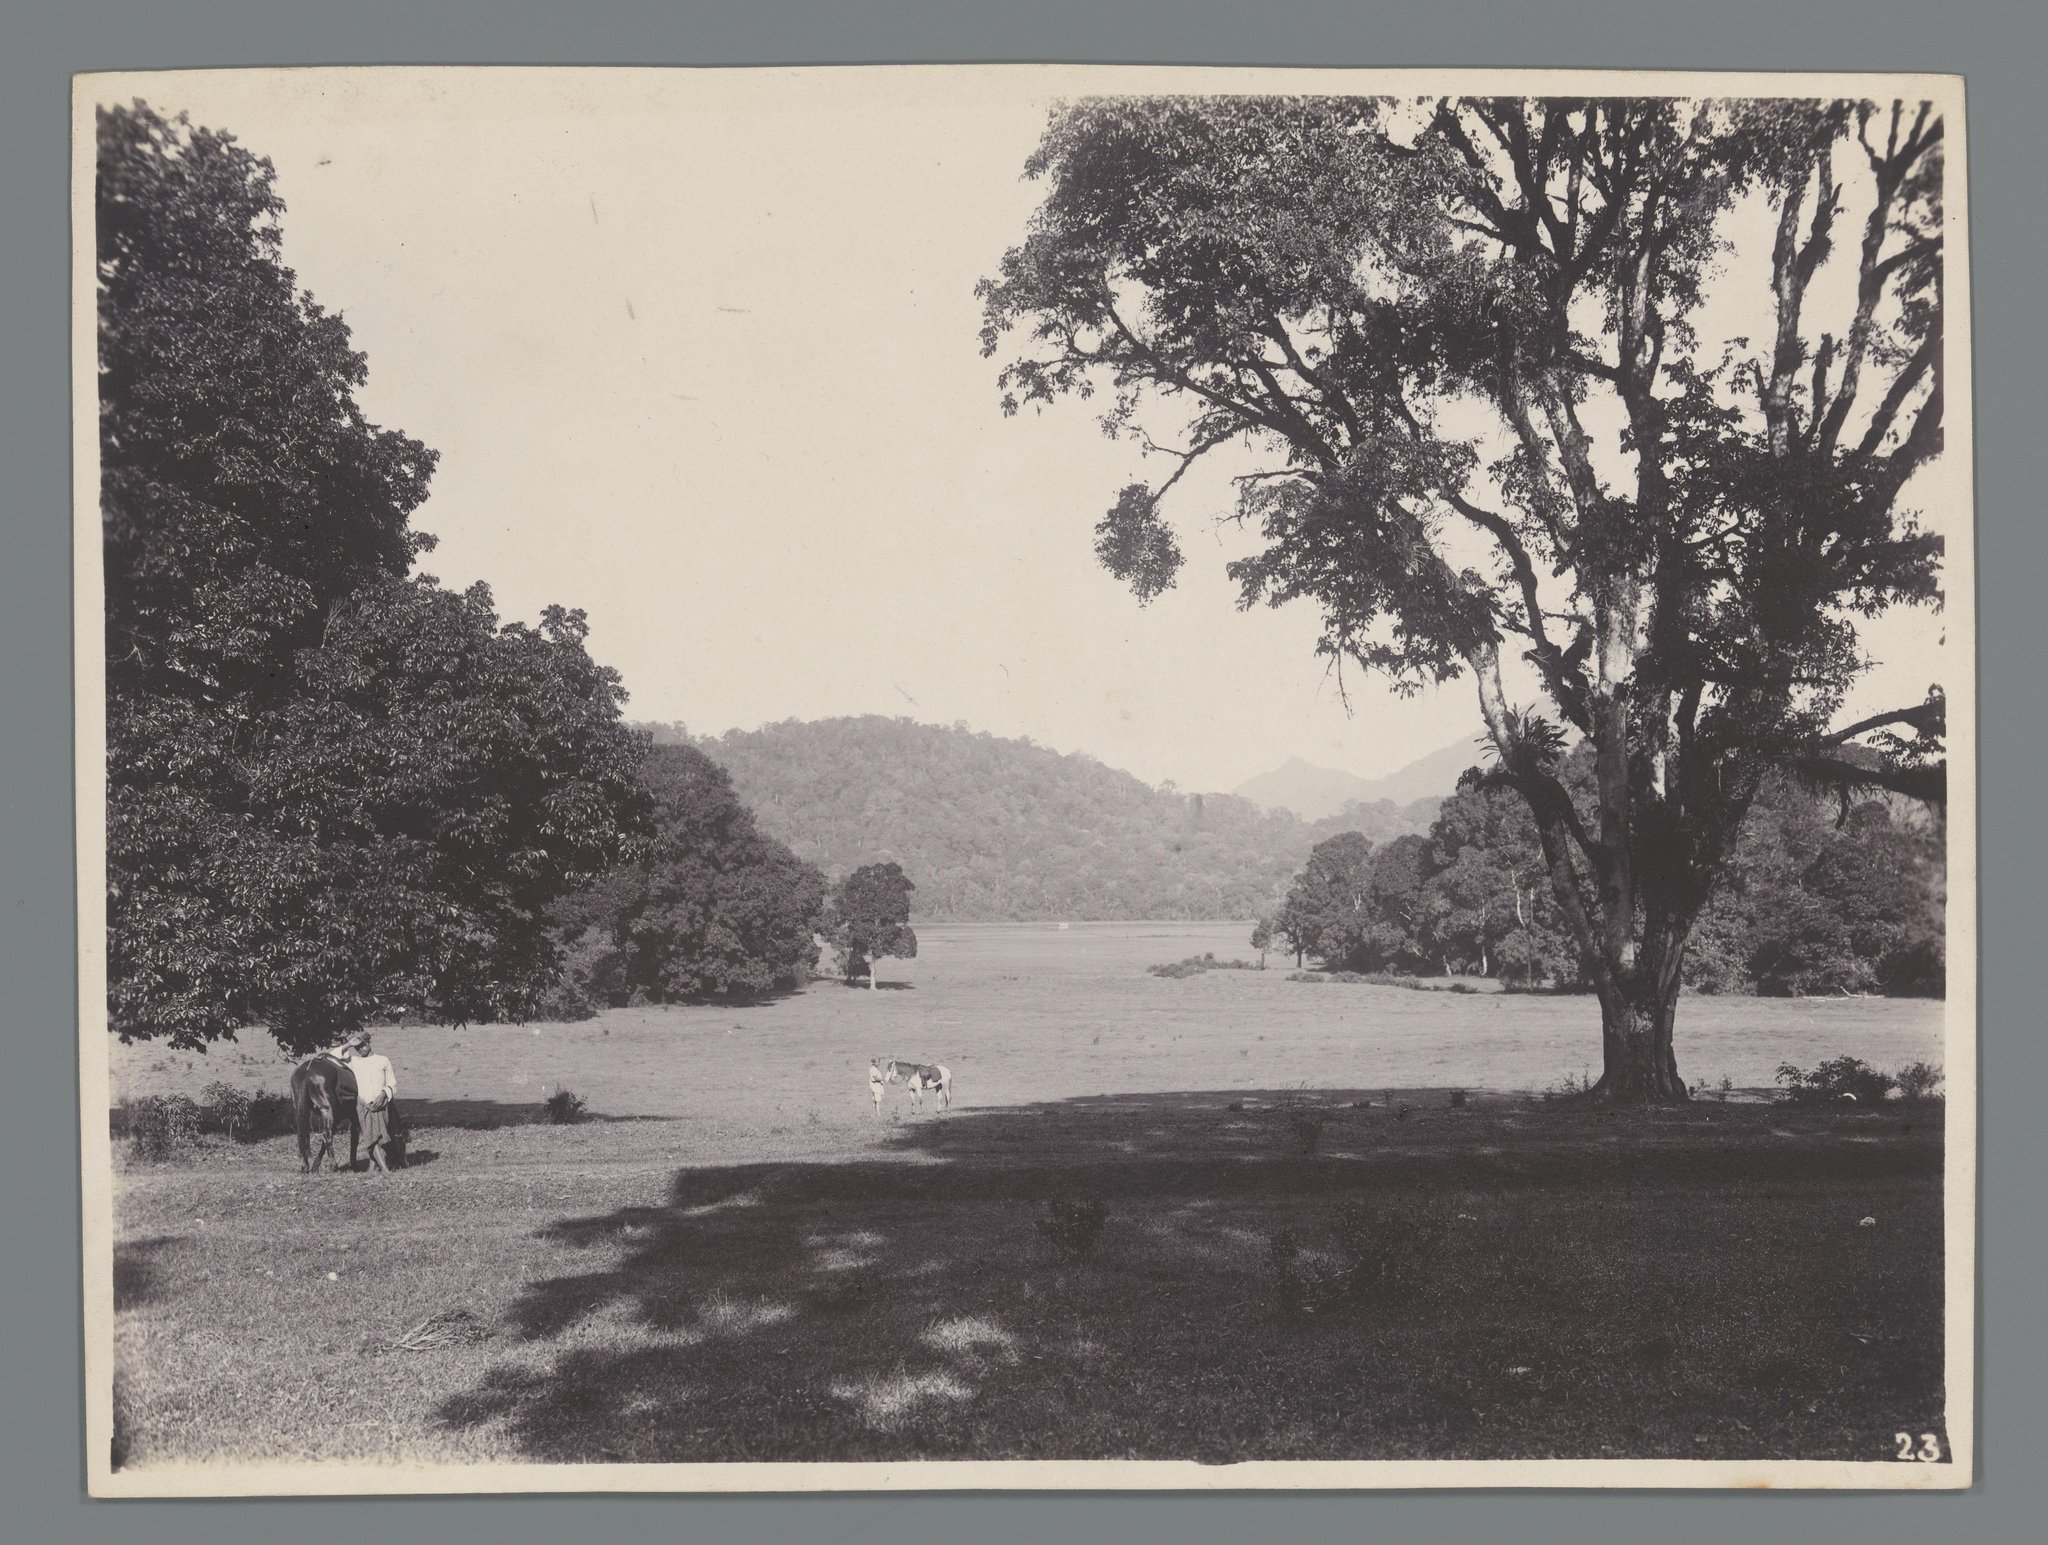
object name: photograph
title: Landschap met paarden, in Indonesië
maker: thilly weissenborn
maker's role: fotograaf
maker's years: 1889-1964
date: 1921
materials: paper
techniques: gelatin silver print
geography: indonesia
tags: horse, indonesia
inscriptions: inscription: ‘Reproductie streng verboden’, number: ‘23’